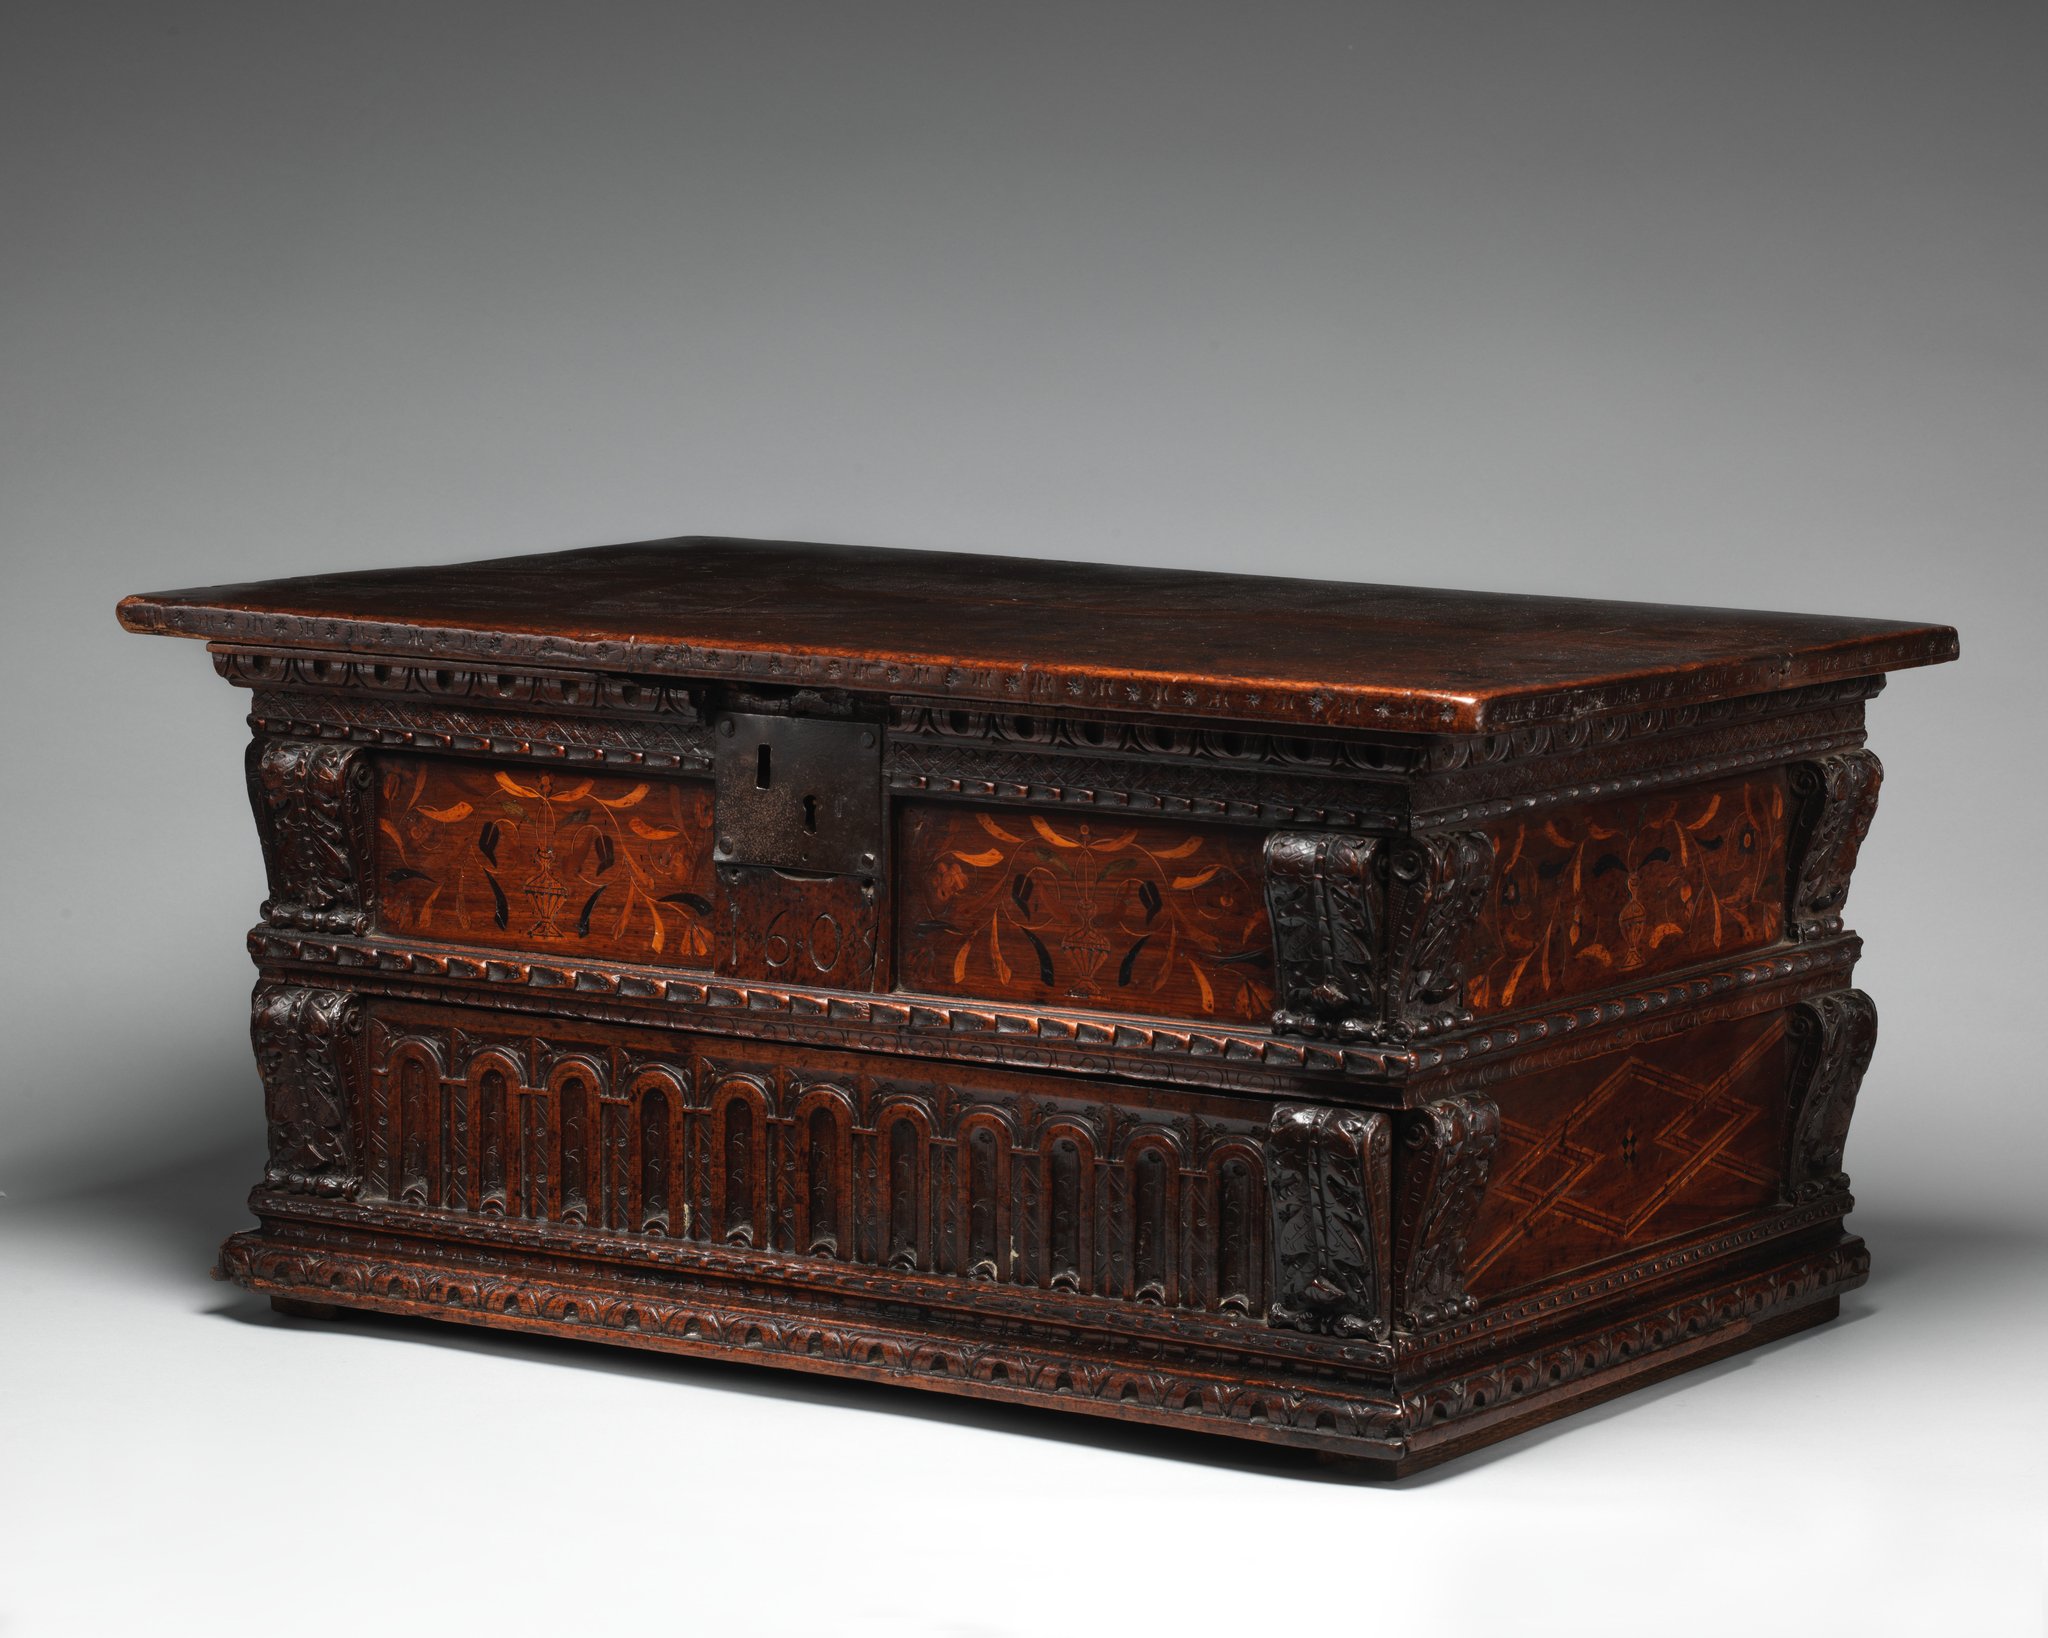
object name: deed box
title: Document box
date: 1603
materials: iron, paper, wood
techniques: printing